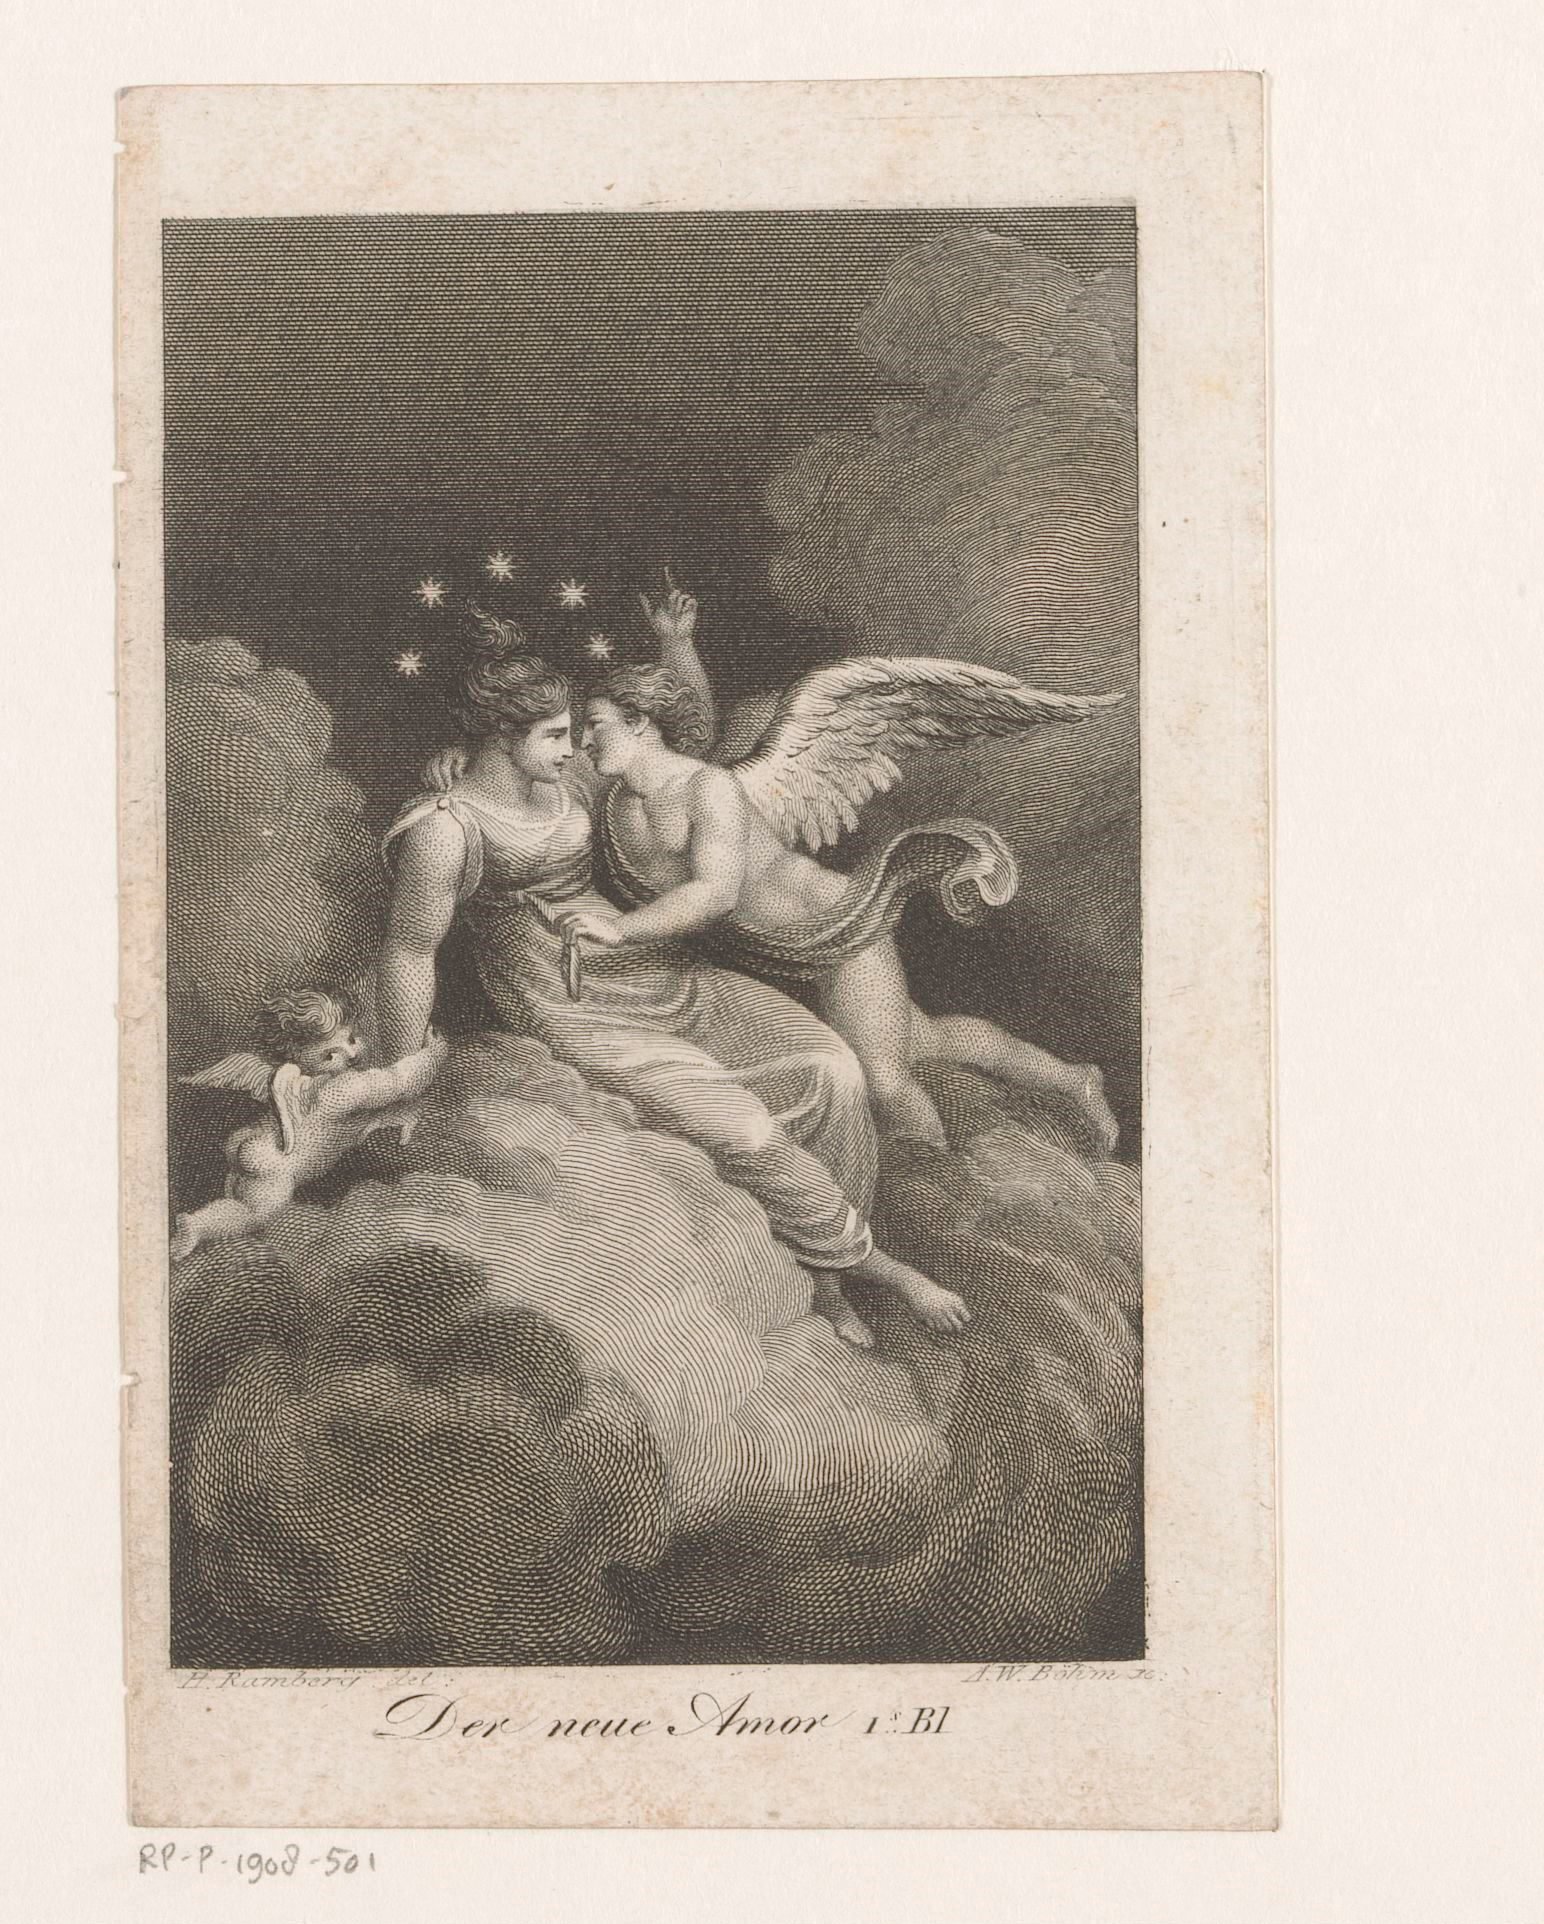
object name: print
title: Amor en Urania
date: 1797-1823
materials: paper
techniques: engraving, etching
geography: leipzig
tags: draughtsman, johann wolfgang von goethe, (story of) cupid, amor (eros), urania (one of the muses); 'urania' (ripa)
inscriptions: collector's mark: Lugt 2228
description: Illustratie bij het gedicht 'Der neue Amor', geschreven door Johann Wolfgang von Goethe in 1792 en voor het eerst gepubliceerd in 1797. De prent is ook gebruikt in de almanak 'Minerva' uit 1823, voor p. XV, pl. 3 (Gallerie zu Göthe's Werken. Dritte Lieferung. Gedichte).